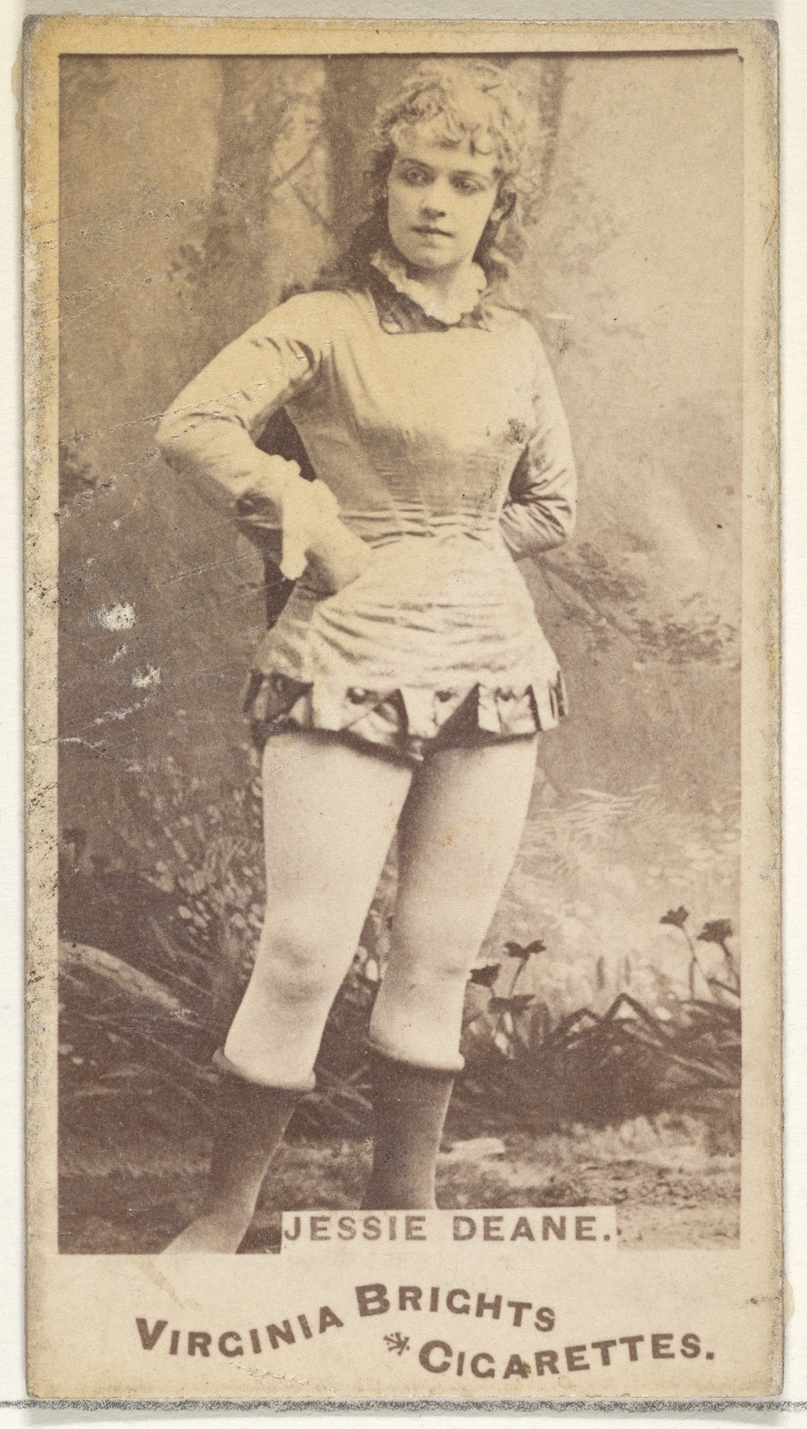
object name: photograph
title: Jessie Deane, from the Actors and Actresses series (N45, Type 1) for Virginia Brights Cigarettes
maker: allen & ginter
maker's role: publisher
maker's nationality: american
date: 1888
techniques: albumen silver print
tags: portraits,women,actresses